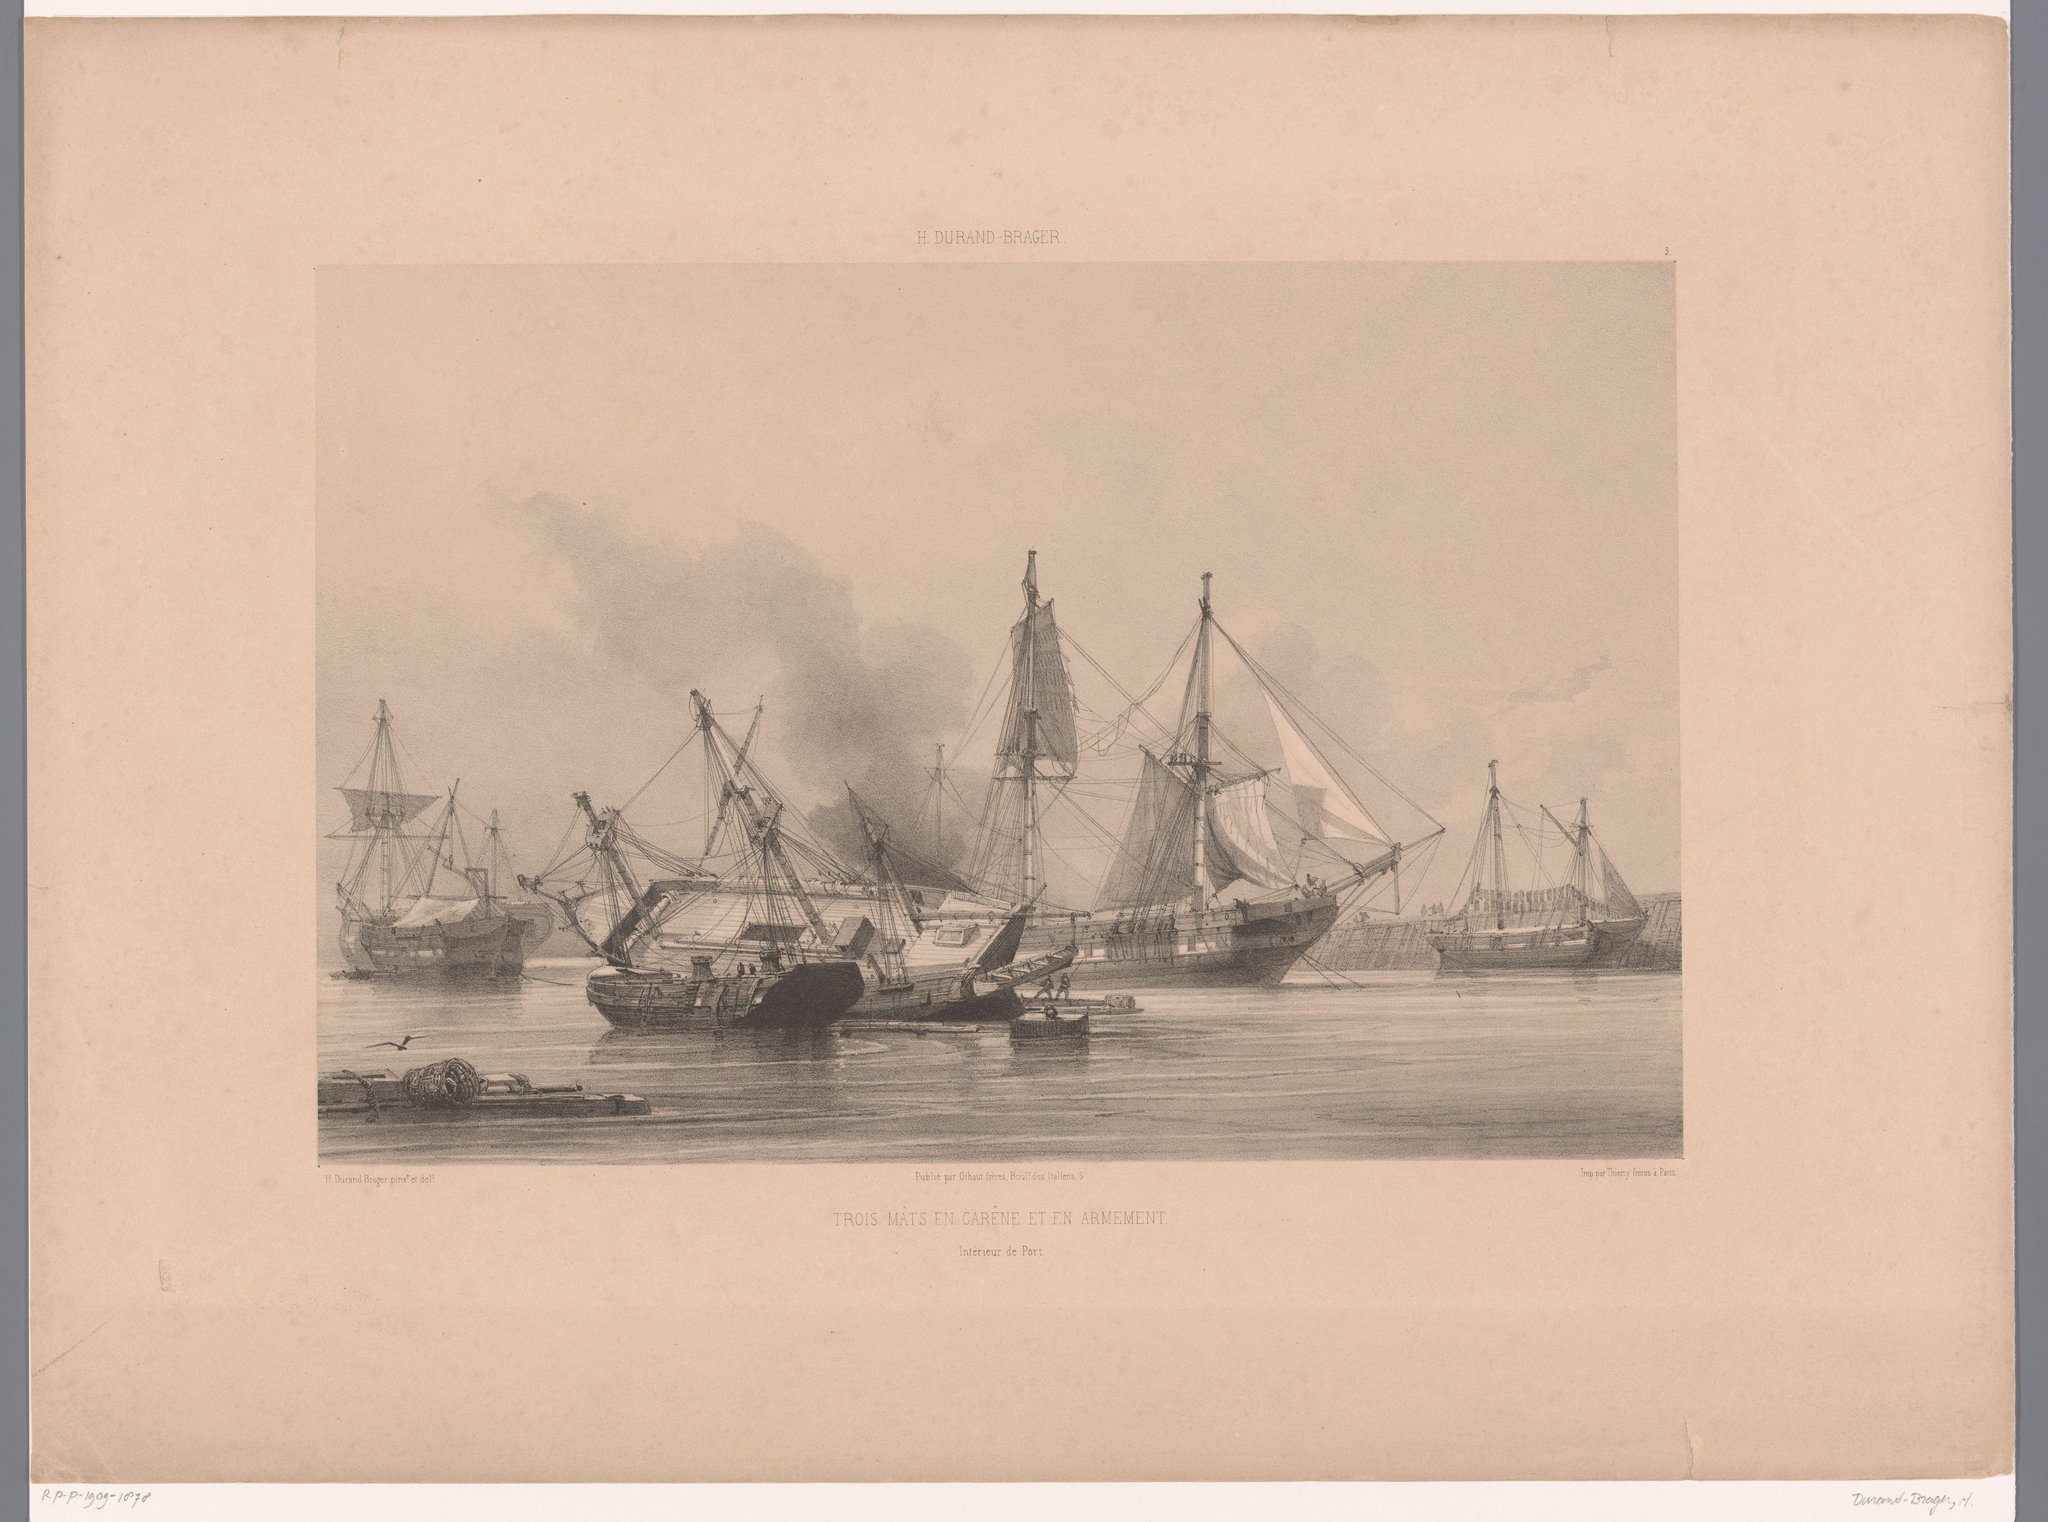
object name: print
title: H. Durand-Brager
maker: jean baptiste henri durand-brager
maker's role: painter, print maker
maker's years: 1814-1879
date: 1847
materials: paper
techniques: tone lithography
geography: paris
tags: harbour, ships (in general) - cc - more than one ship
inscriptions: check stamp:, collector's mark: Lugt 2228a